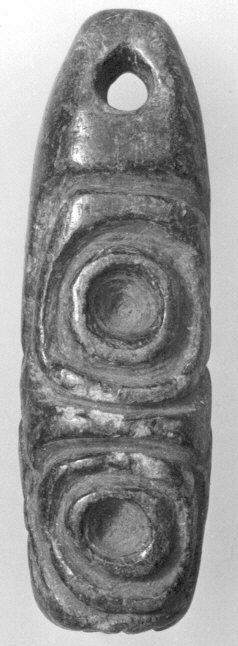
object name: pendant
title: Pendant or seal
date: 6000-4001 BCE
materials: stone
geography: cyprus